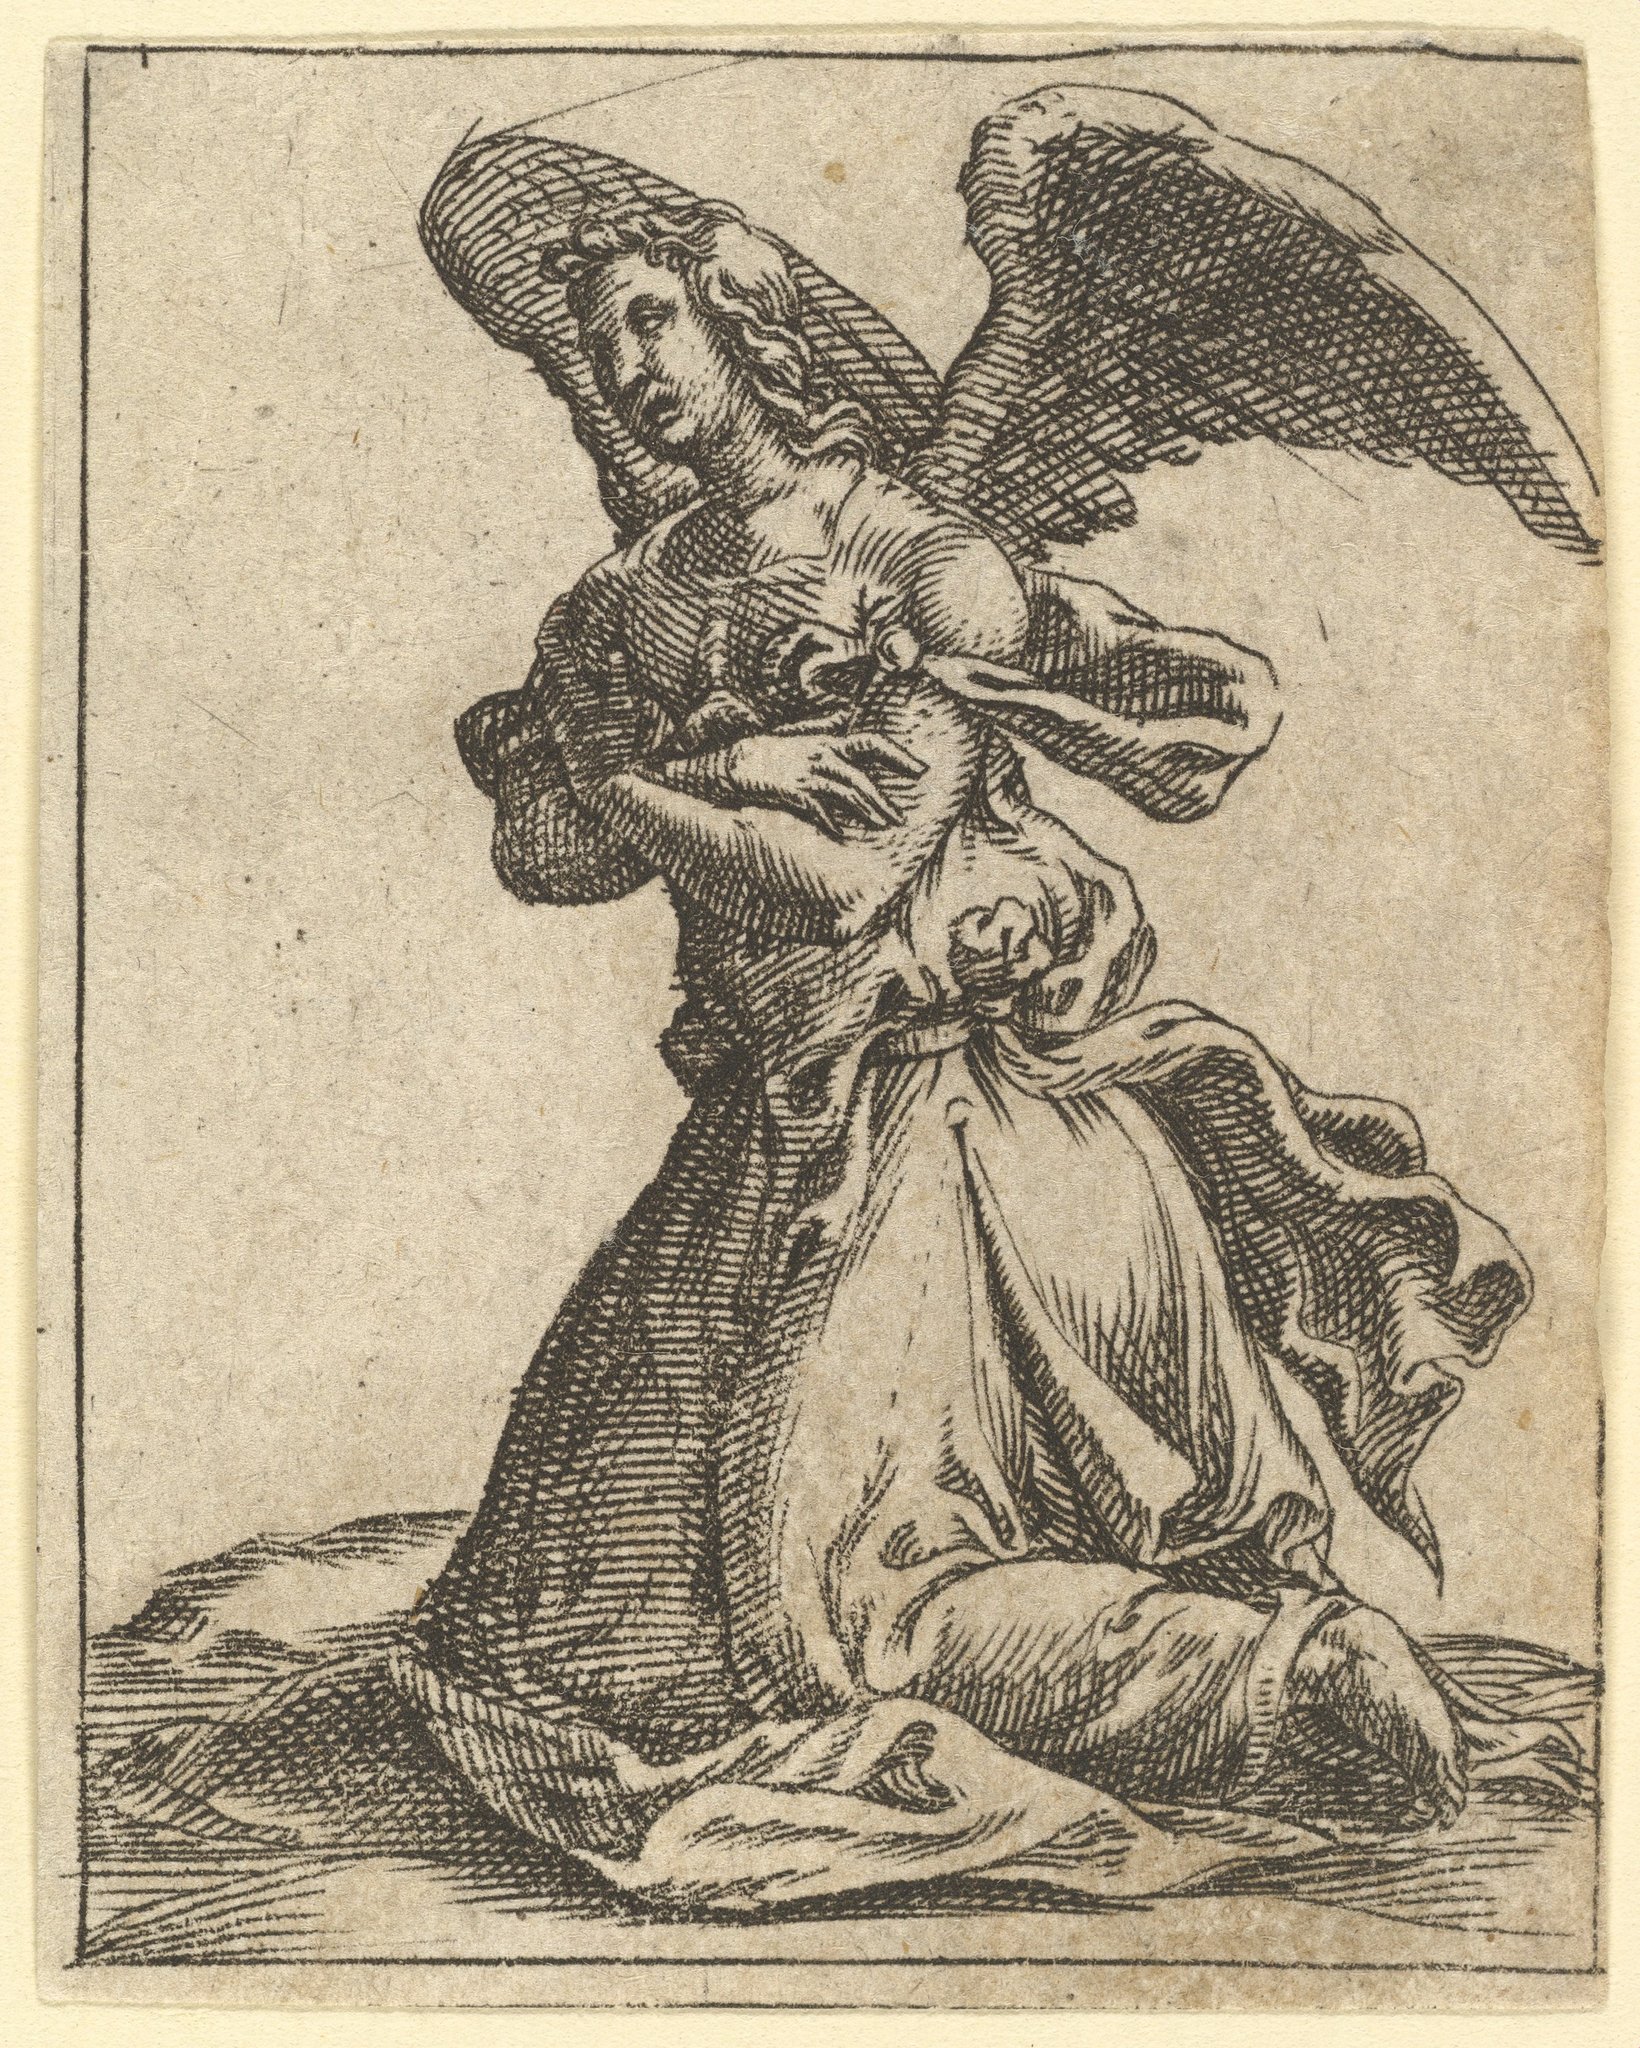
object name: print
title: The Virgin of Sorrows: Angel; one of nine surrounding compartments from the Virgin of Sorrows, now separated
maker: giorgio ghisi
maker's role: artist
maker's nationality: italian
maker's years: 1515-1582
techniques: engraving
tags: angels